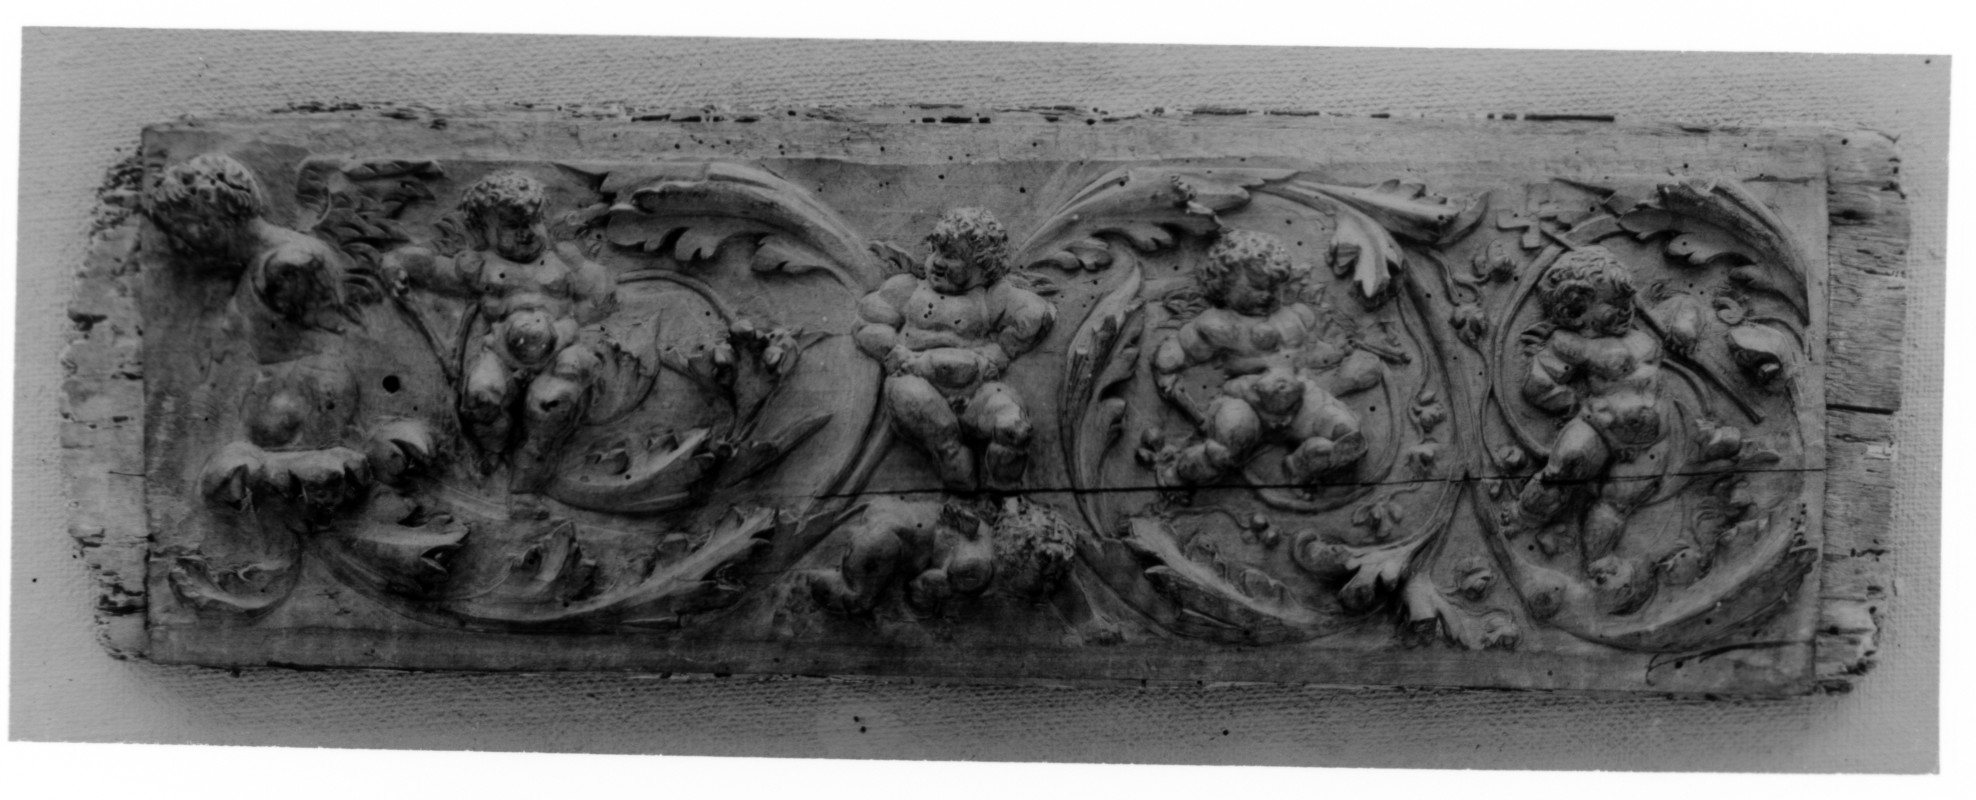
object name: frieze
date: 1501-1550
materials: wood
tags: putti